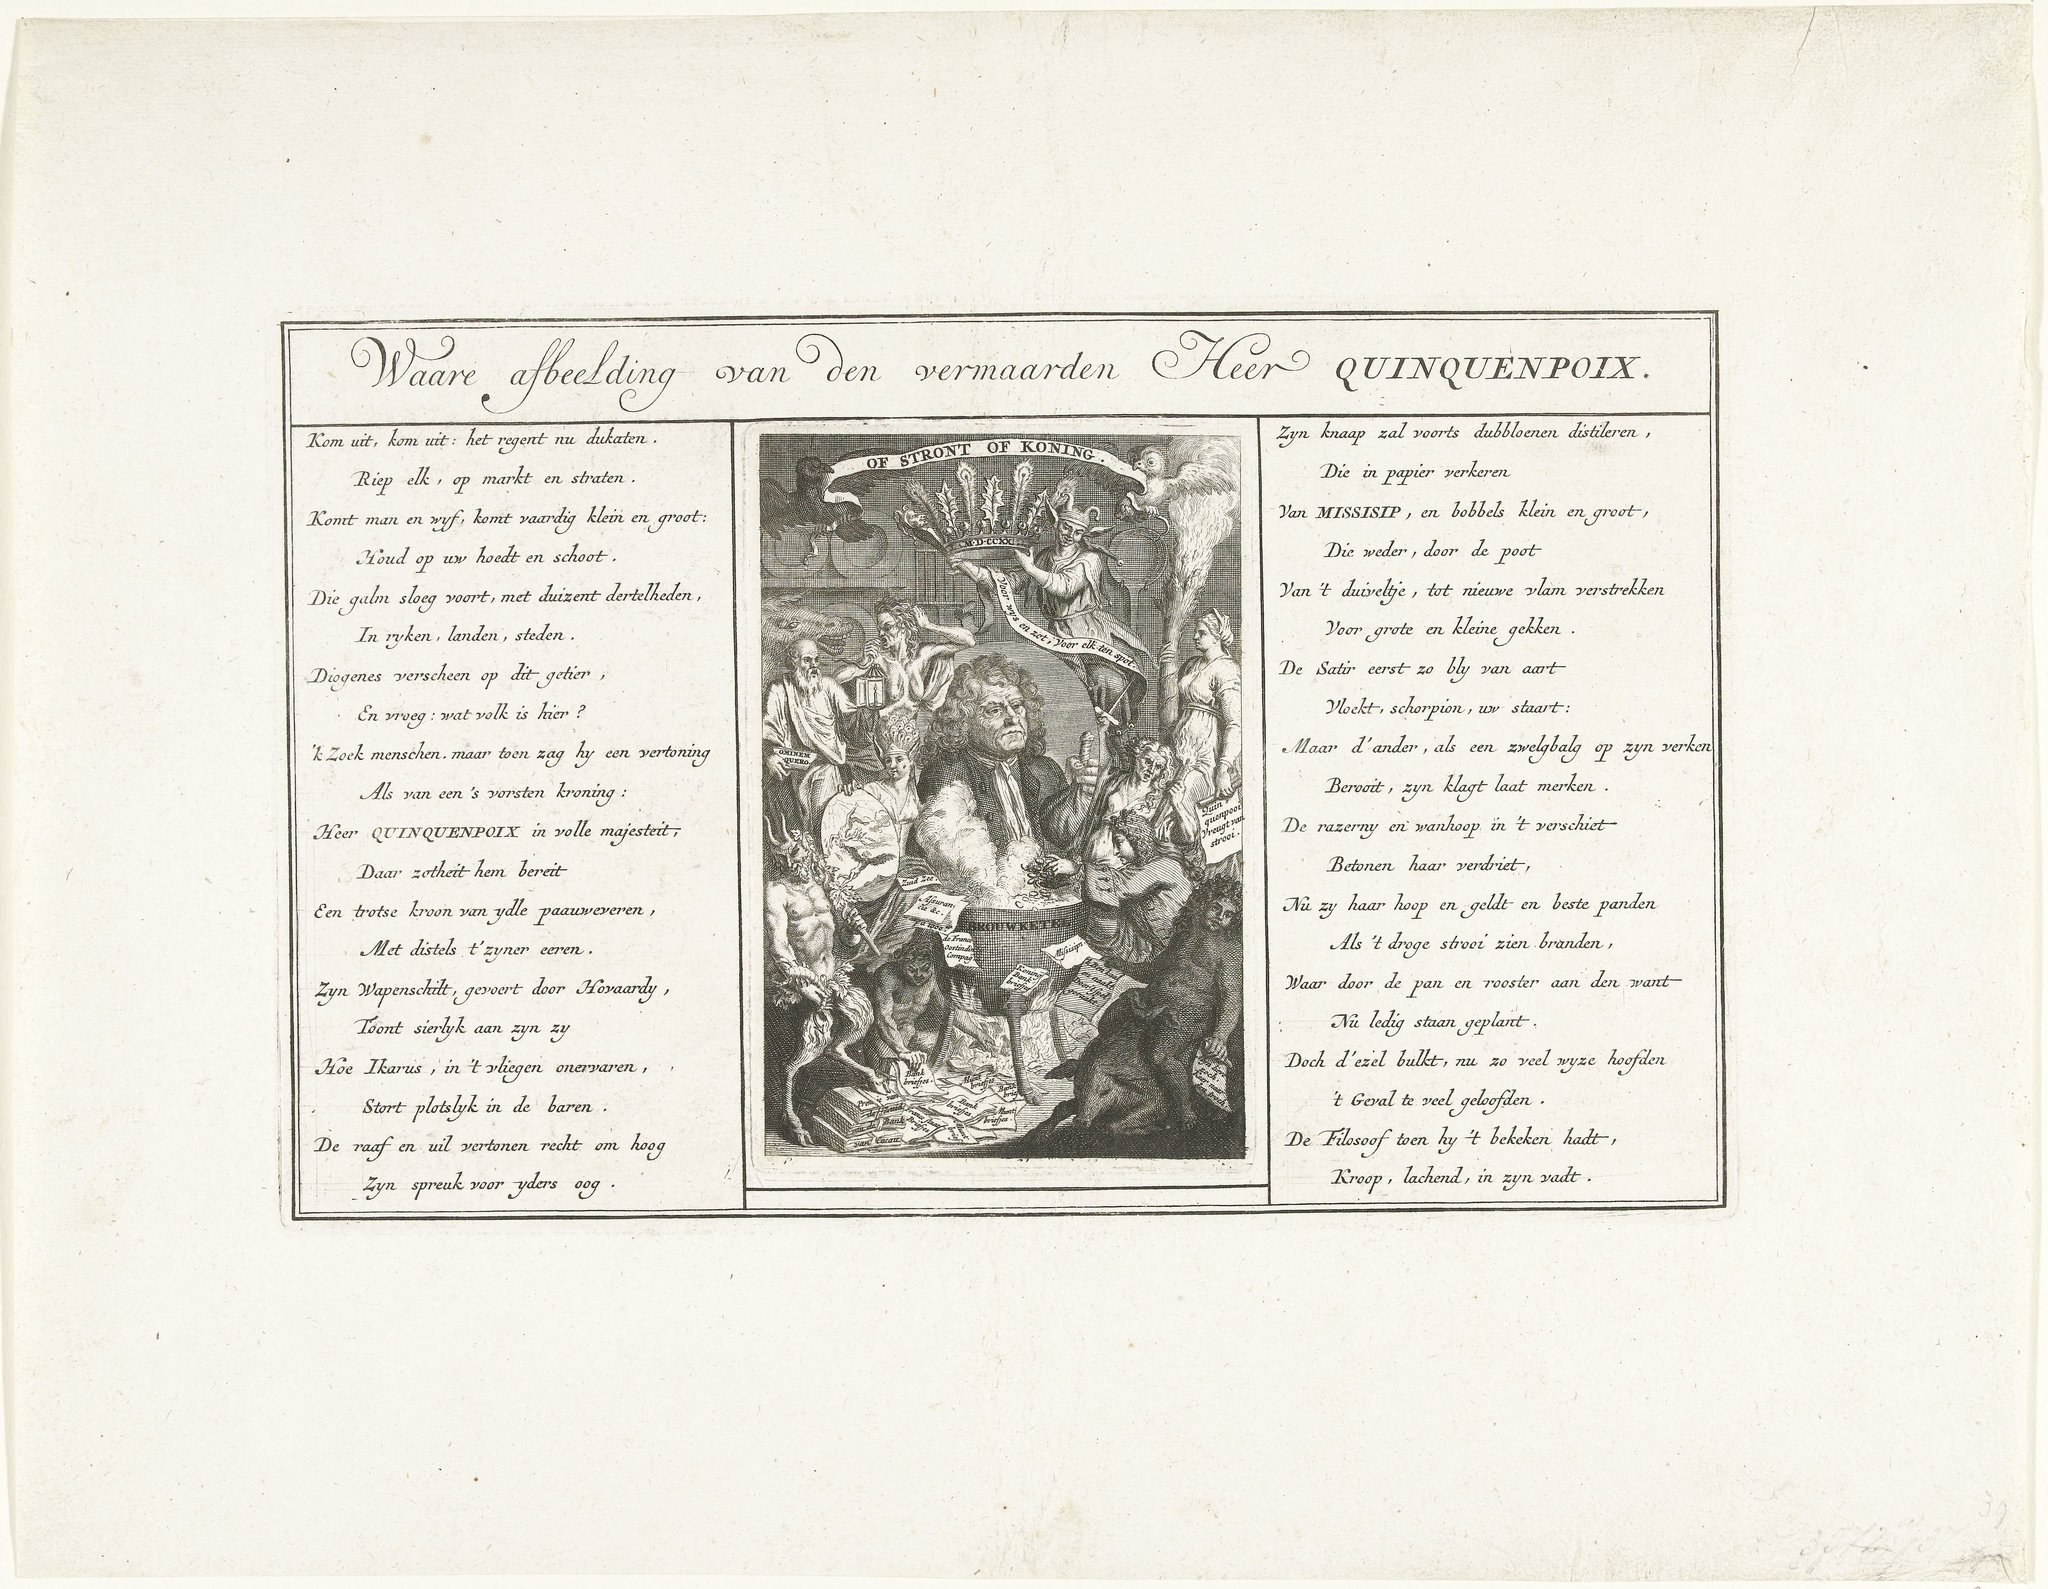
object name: print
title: Ware afbeelding van de heer Quinquempoix, 1720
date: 1712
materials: paper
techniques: engraving, etching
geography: southern netherlands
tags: brewing, boiling (in a cauldron); witches' kitchen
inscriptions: collector's mark: Lugt 2228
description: Ware afbeelding van de heer Quinquempoix. Portretmedaillon van John Law als de heer Quinquempoix boven een brouwketel waarin geldstukken worden omgetoverd tot aandelen. Heksenketel met duivels, uilen etc. Boven het portret de Zotheid met een kroon van pauwenveren en hulstbladeren. Hierboven een banderol met: Of Stront of Koning. Deze plaat afgedrukt binnen een grotere plaat met titel en verzen in het Nederlands aan weerszijden. Prent 37 in de serie Het Groote Tafereel der Dwaasheid met spotprenten op de Windhandel of Actiehandel van 1720.